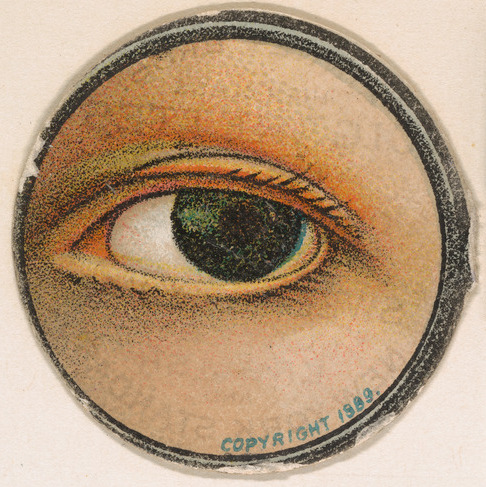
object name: print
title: Monocle and Eye (dark blue), from Jocular Ocular series (N221) issued by Kinney Bros.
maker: kinney brothers tobacco company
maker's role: publisher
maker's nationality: american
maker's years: 1869-2011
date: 1889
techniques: color lithograph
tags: eyes